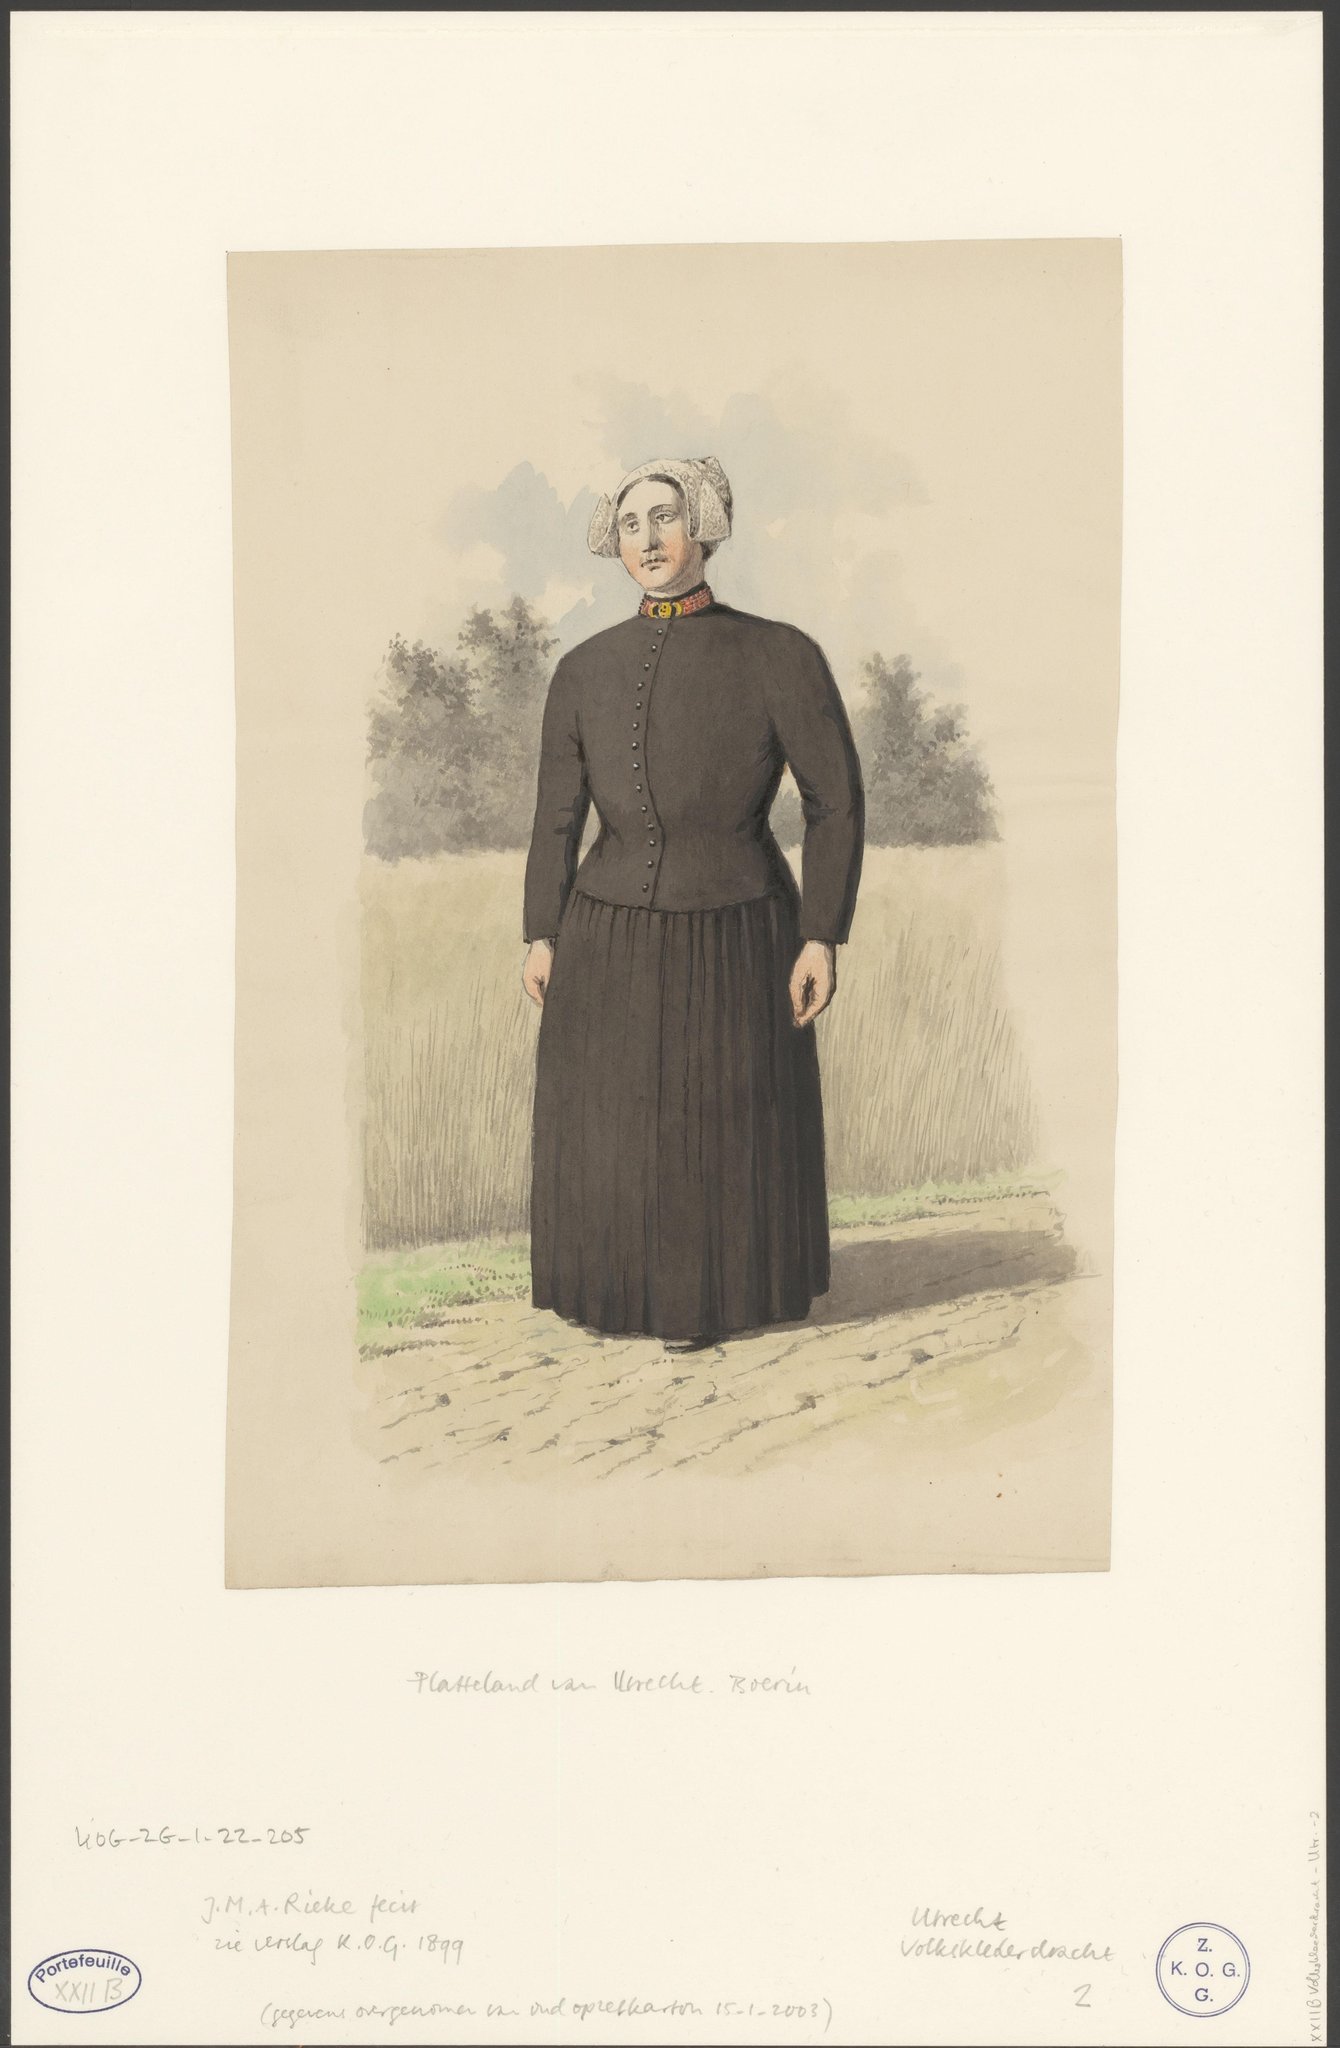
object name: drawing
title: Boerin van het platteland van Utrecht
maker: johan martinus anthon rieke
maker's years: 1851-1899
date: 1896-1898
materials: paper, watercolor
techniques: brush, hand coloring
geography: netherlands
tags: farmers - aa - female farmer, farmer's wife, clothes, costume (+ women's clothes), folk costume, regional costume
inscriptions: collector's mark, collector's mark: Lugt 1641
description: Boerin van het platteland van Utrecht. Tekening vervaardigd voor de tentoonstelling over Nederlandse klederdrachten gehouden in het Stedelijk Museum te Amsterdam in september 1898. Onderwerpsrubrieken binnen de Atlas Zeden en Gewoonten: De Kleeding, Volkskleederdracht, Utrecht.